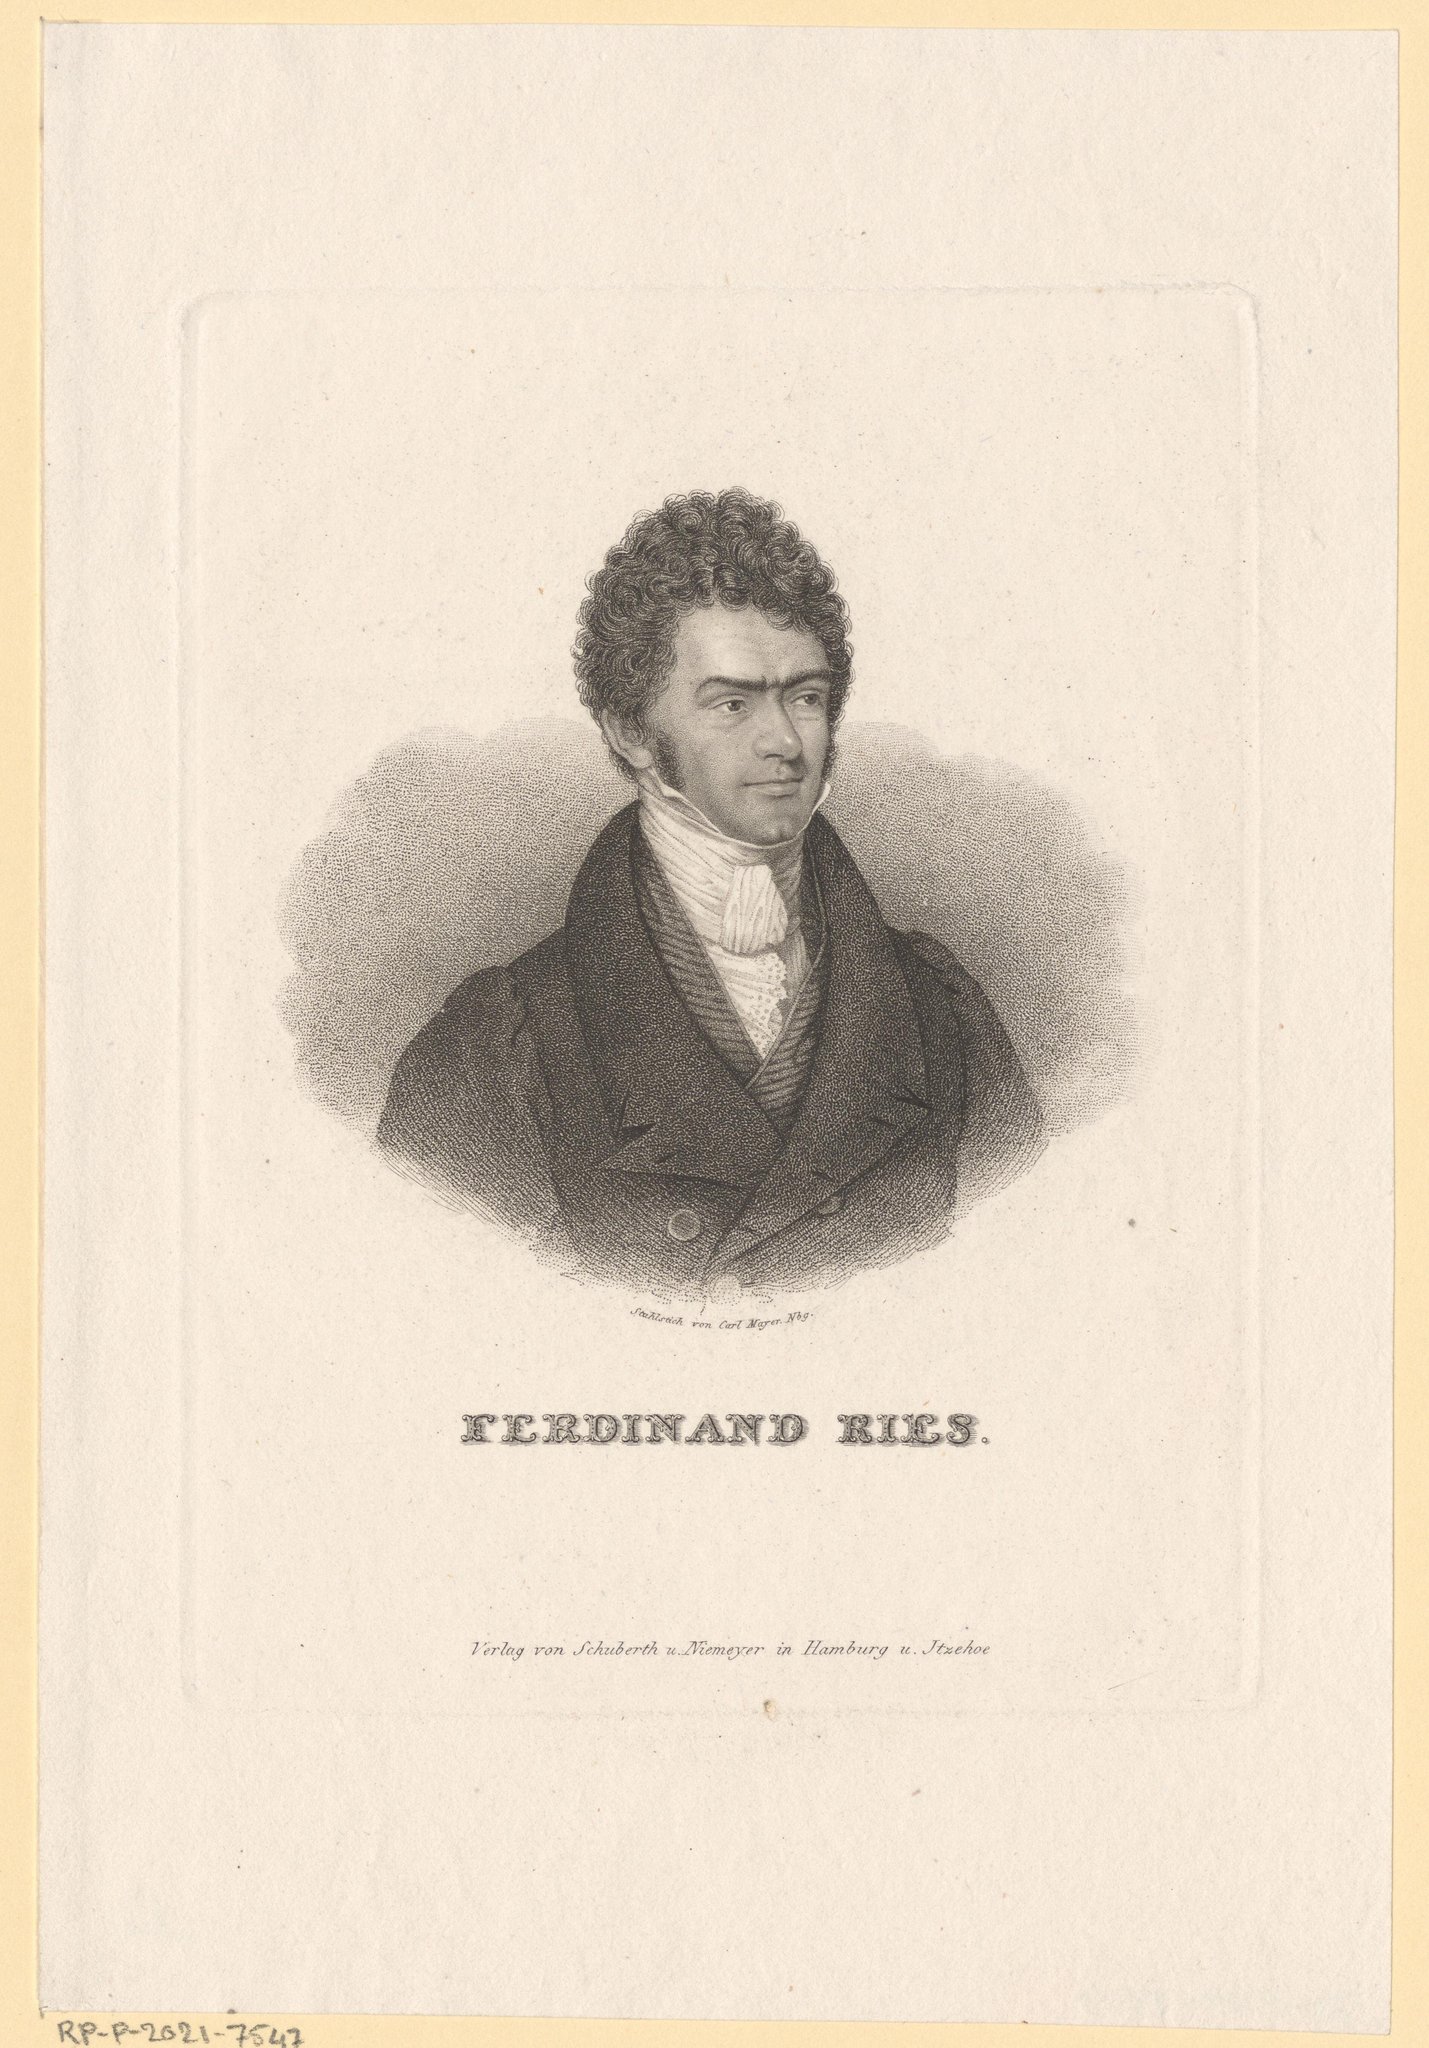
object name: print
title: Portret van Ferdinand Ries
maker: carl mayer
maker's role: print maker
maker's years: 1798-1868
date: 1829-1839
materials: paper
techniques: engraving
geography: hamburg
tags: historical persons